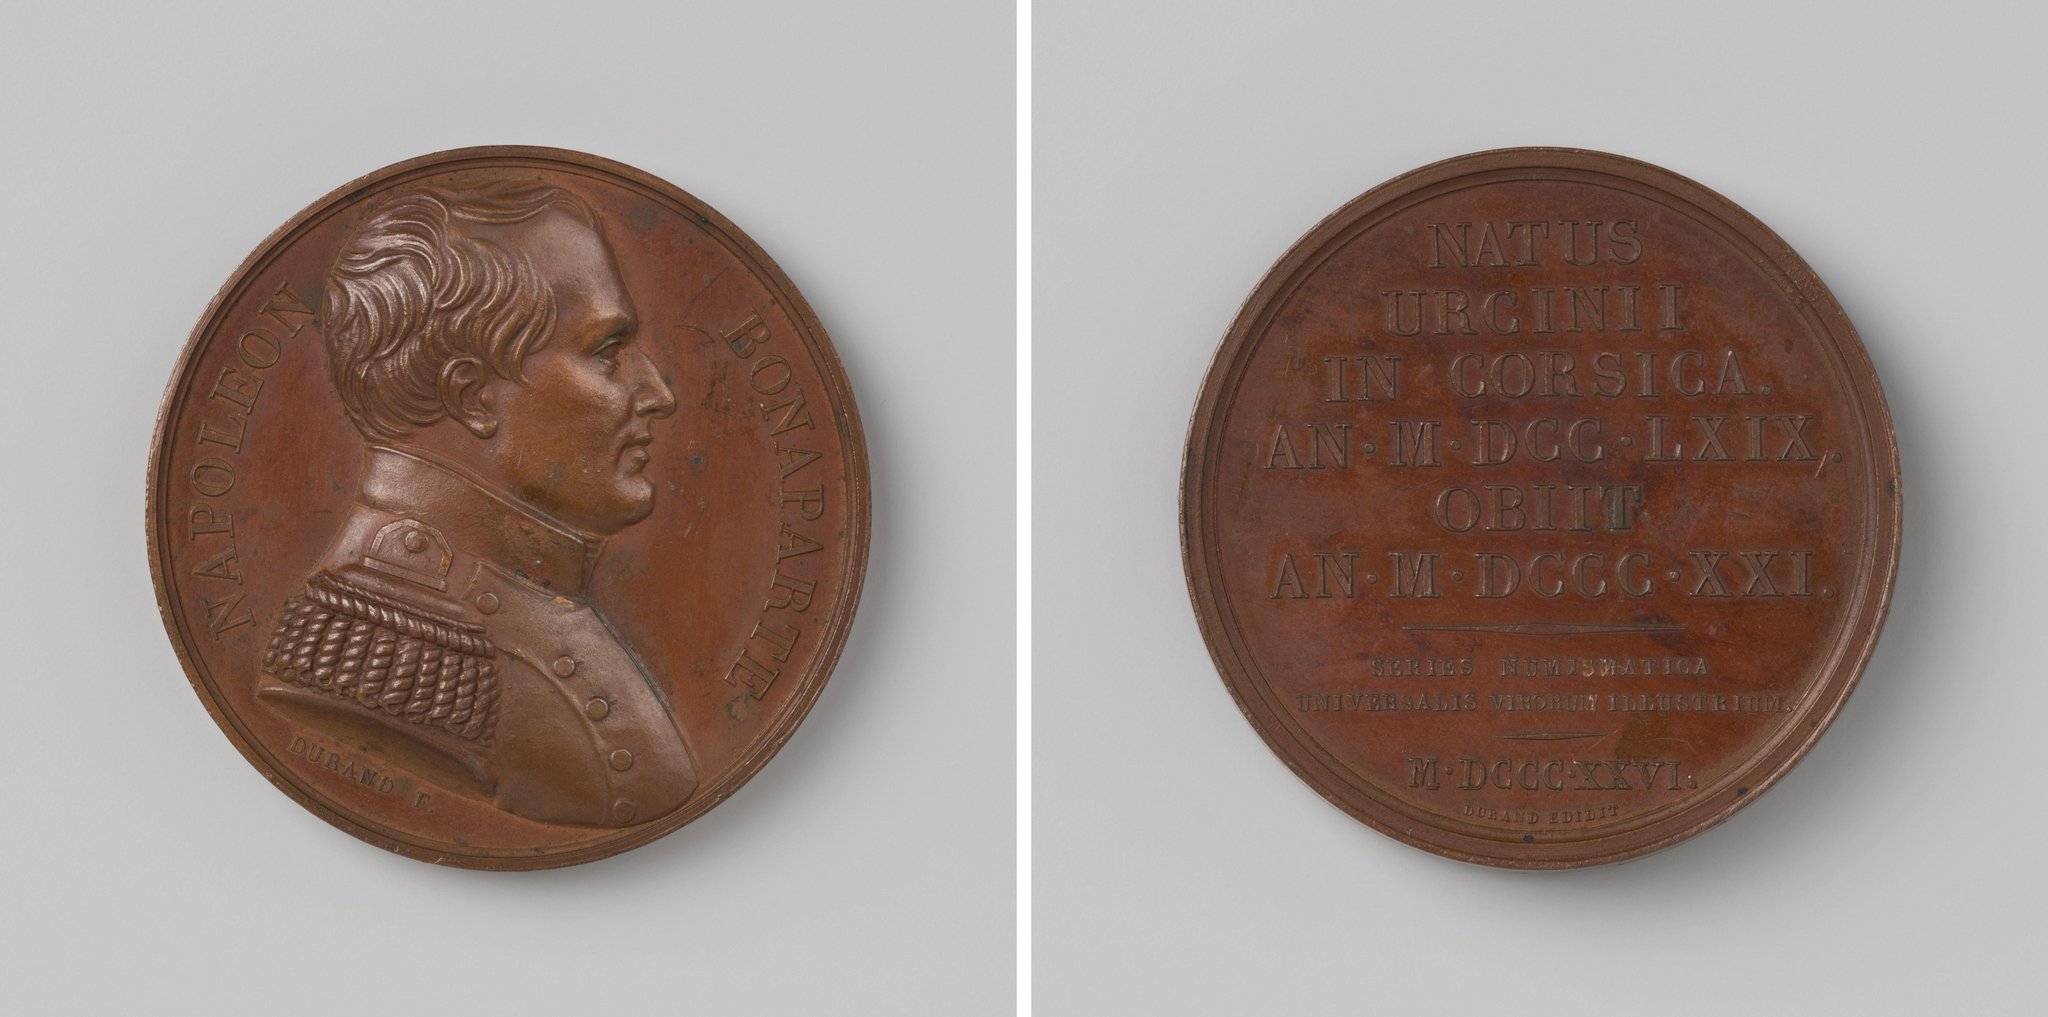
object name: history medal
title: Napoleon Bonaparte, beroemde Fransman, uit de serie Numismatica Universalis Virorum Illustrium door Amédée Durand.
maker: amédée pierre durand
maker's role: publisher, sculptor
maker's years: 1789-1873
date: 1826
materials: bronze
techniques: striking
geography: paris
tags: napoleon i (emperor of the french)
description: Bronzen penning. Voorzijde: borststuk man binnen omschrift. Keerzijde: opschrift